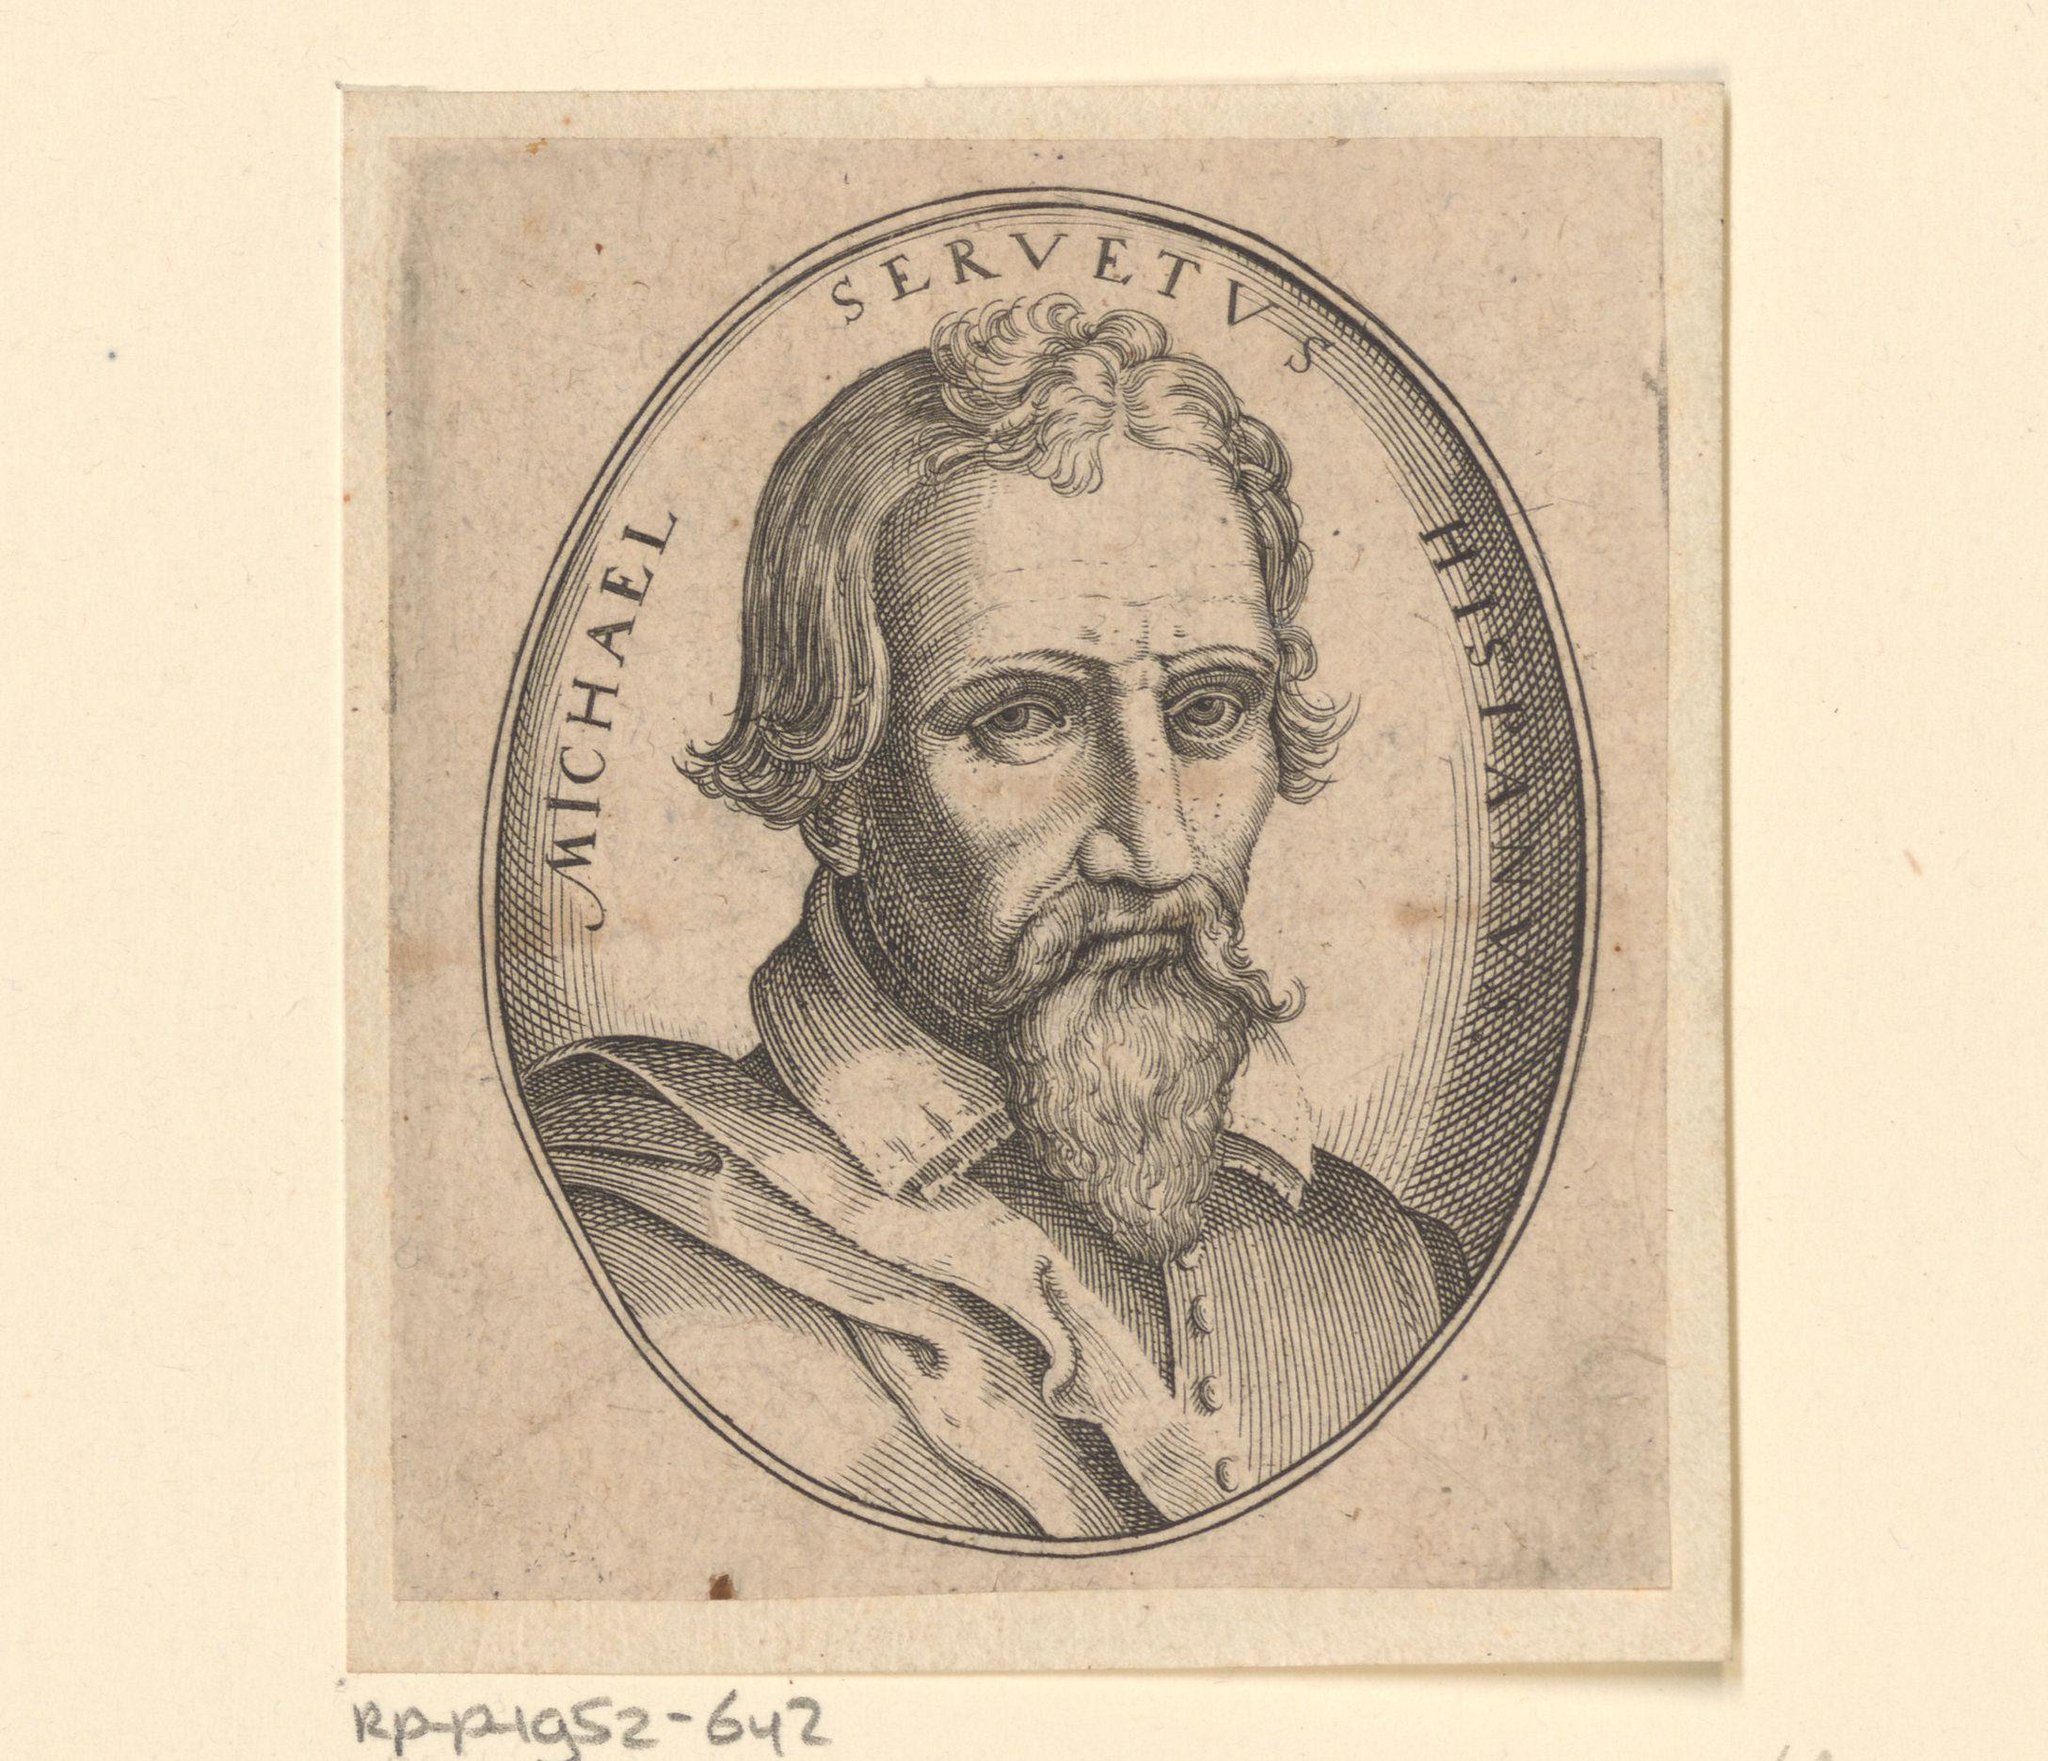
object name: print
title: Portret van Michael Servet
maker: Anonymous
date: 1600-1799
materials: paper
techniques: engraving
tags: theologian, historical persons, physician, doctor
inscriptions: collector's mark: Lugt 2228, collector's mark: Lugt 2760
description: Met tekst in het Latijn rondom het portret.